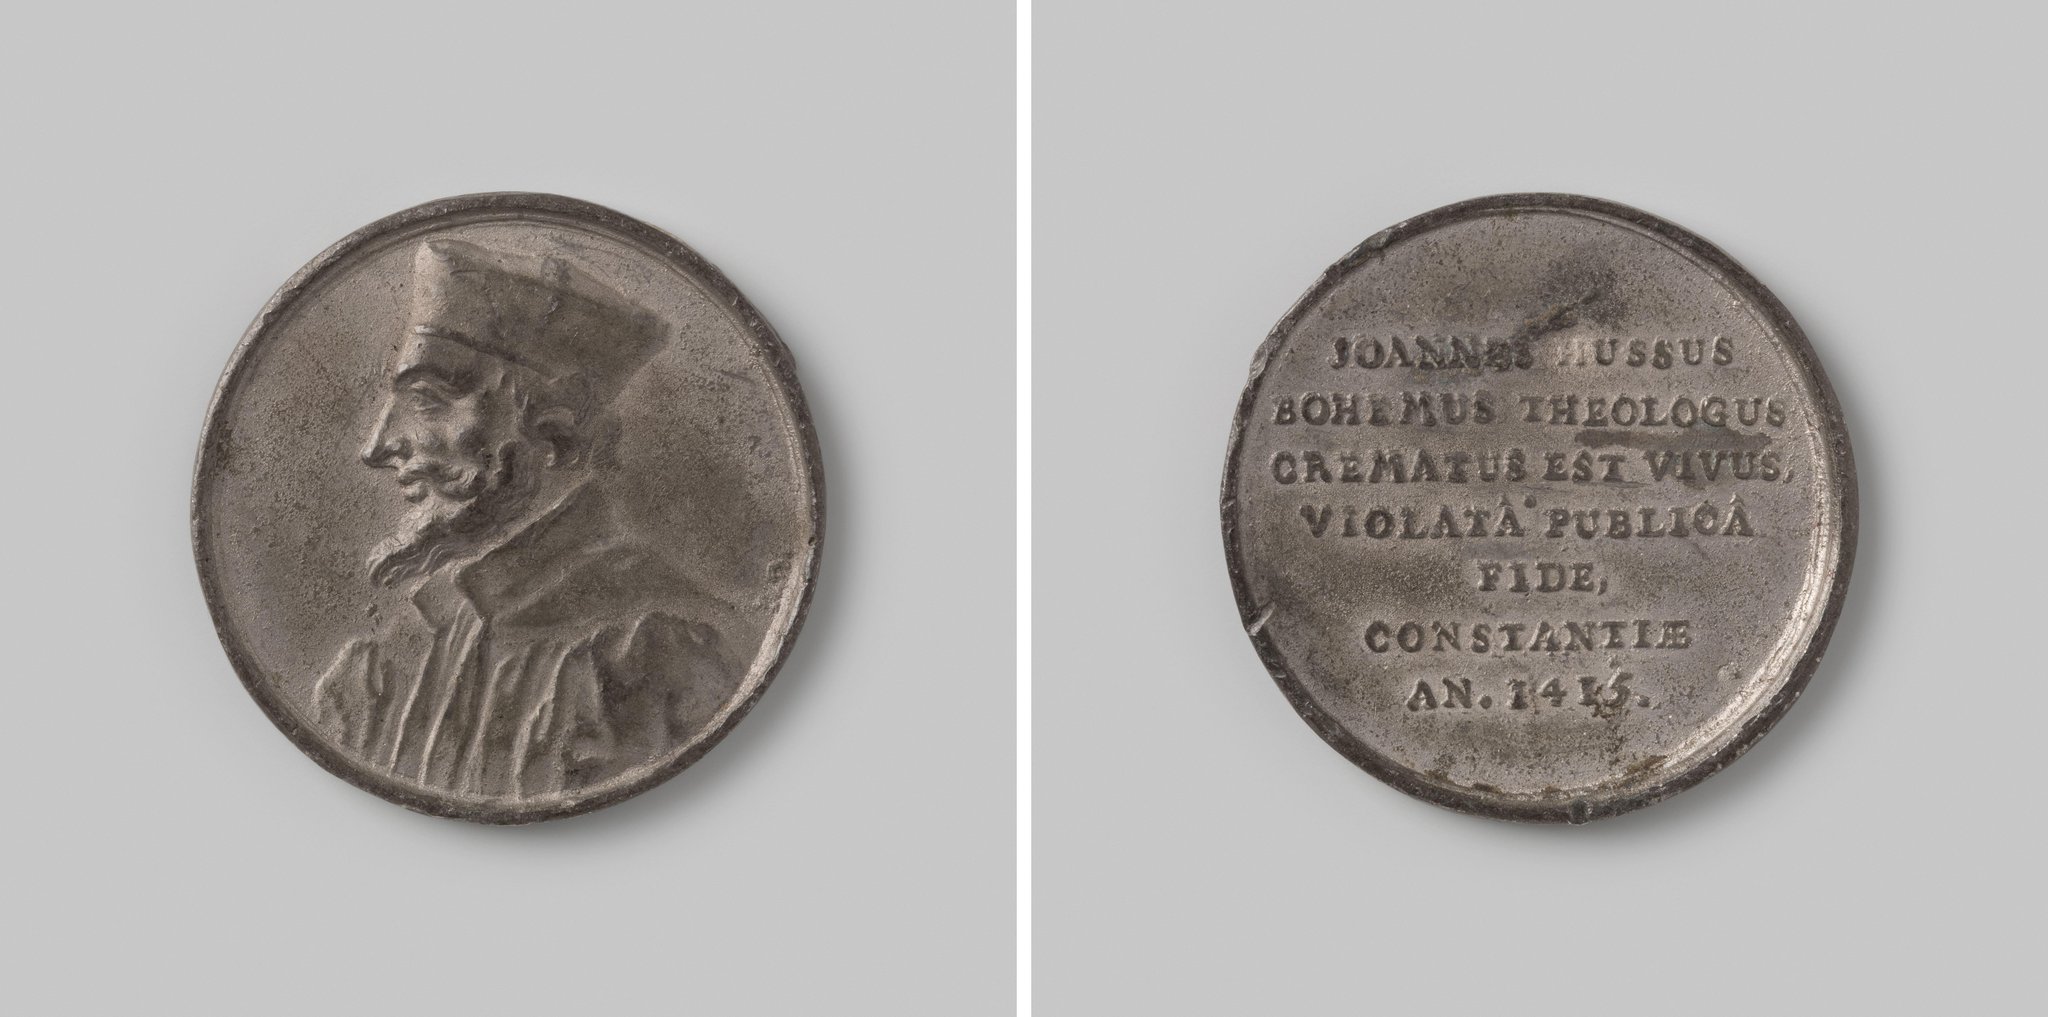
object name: history medal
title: Johannes Hus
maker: jean dassier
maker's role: medailleur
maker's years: 1676-1763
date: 1710-1730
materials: tin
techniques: striking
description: Tinnen penning, op de voorzijde het borstbeeld van Hus naar links, op de keerzijde zeven regels tekst.